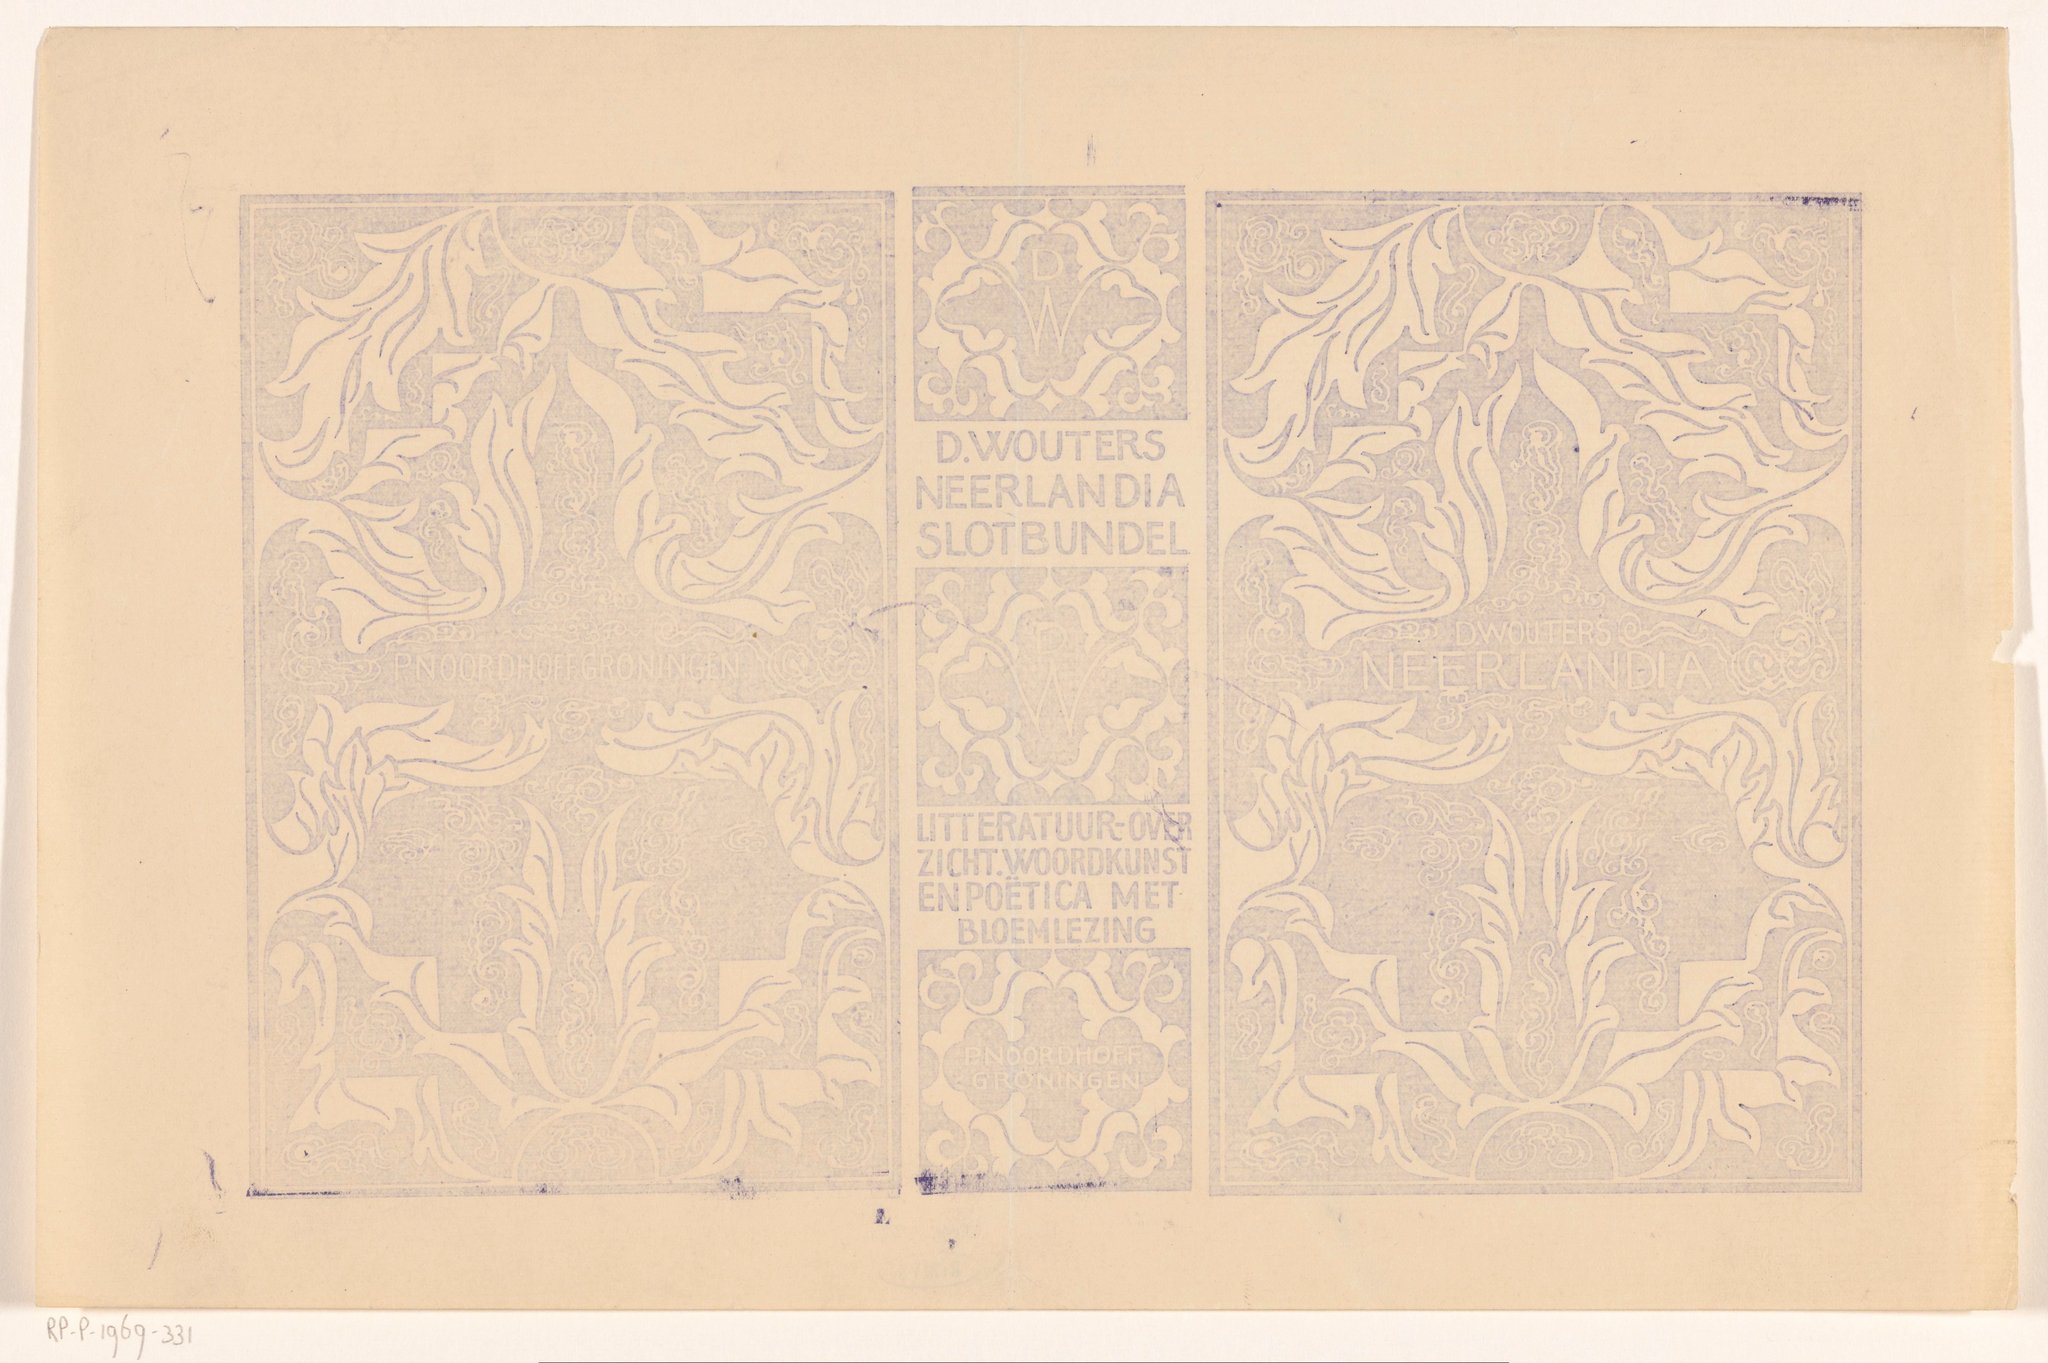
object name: print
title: Omslagontwerp voor: D. Wouters, Neerlandia, 1924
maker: carel adolph lion cachet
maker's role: draughtsman, print maker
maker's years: 1864-1945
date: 1924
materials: paper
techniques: printing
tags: douwe wouters, foliage, tendrils, branches ~ ornament - aa - stylized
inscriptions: collector's mark: Lugt 2228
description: Boekomslag met een patroon van bladeren. Links de achterzijde, in het midden de rug en rechts de voorzijde van het omslag. Op de rug de tekst 'D. Wouters Neerlandia Slotbundel. Literatuur-overzicht. Woordkunst en poëtica met bloemlezing. P. Noordhoff Groningen'.